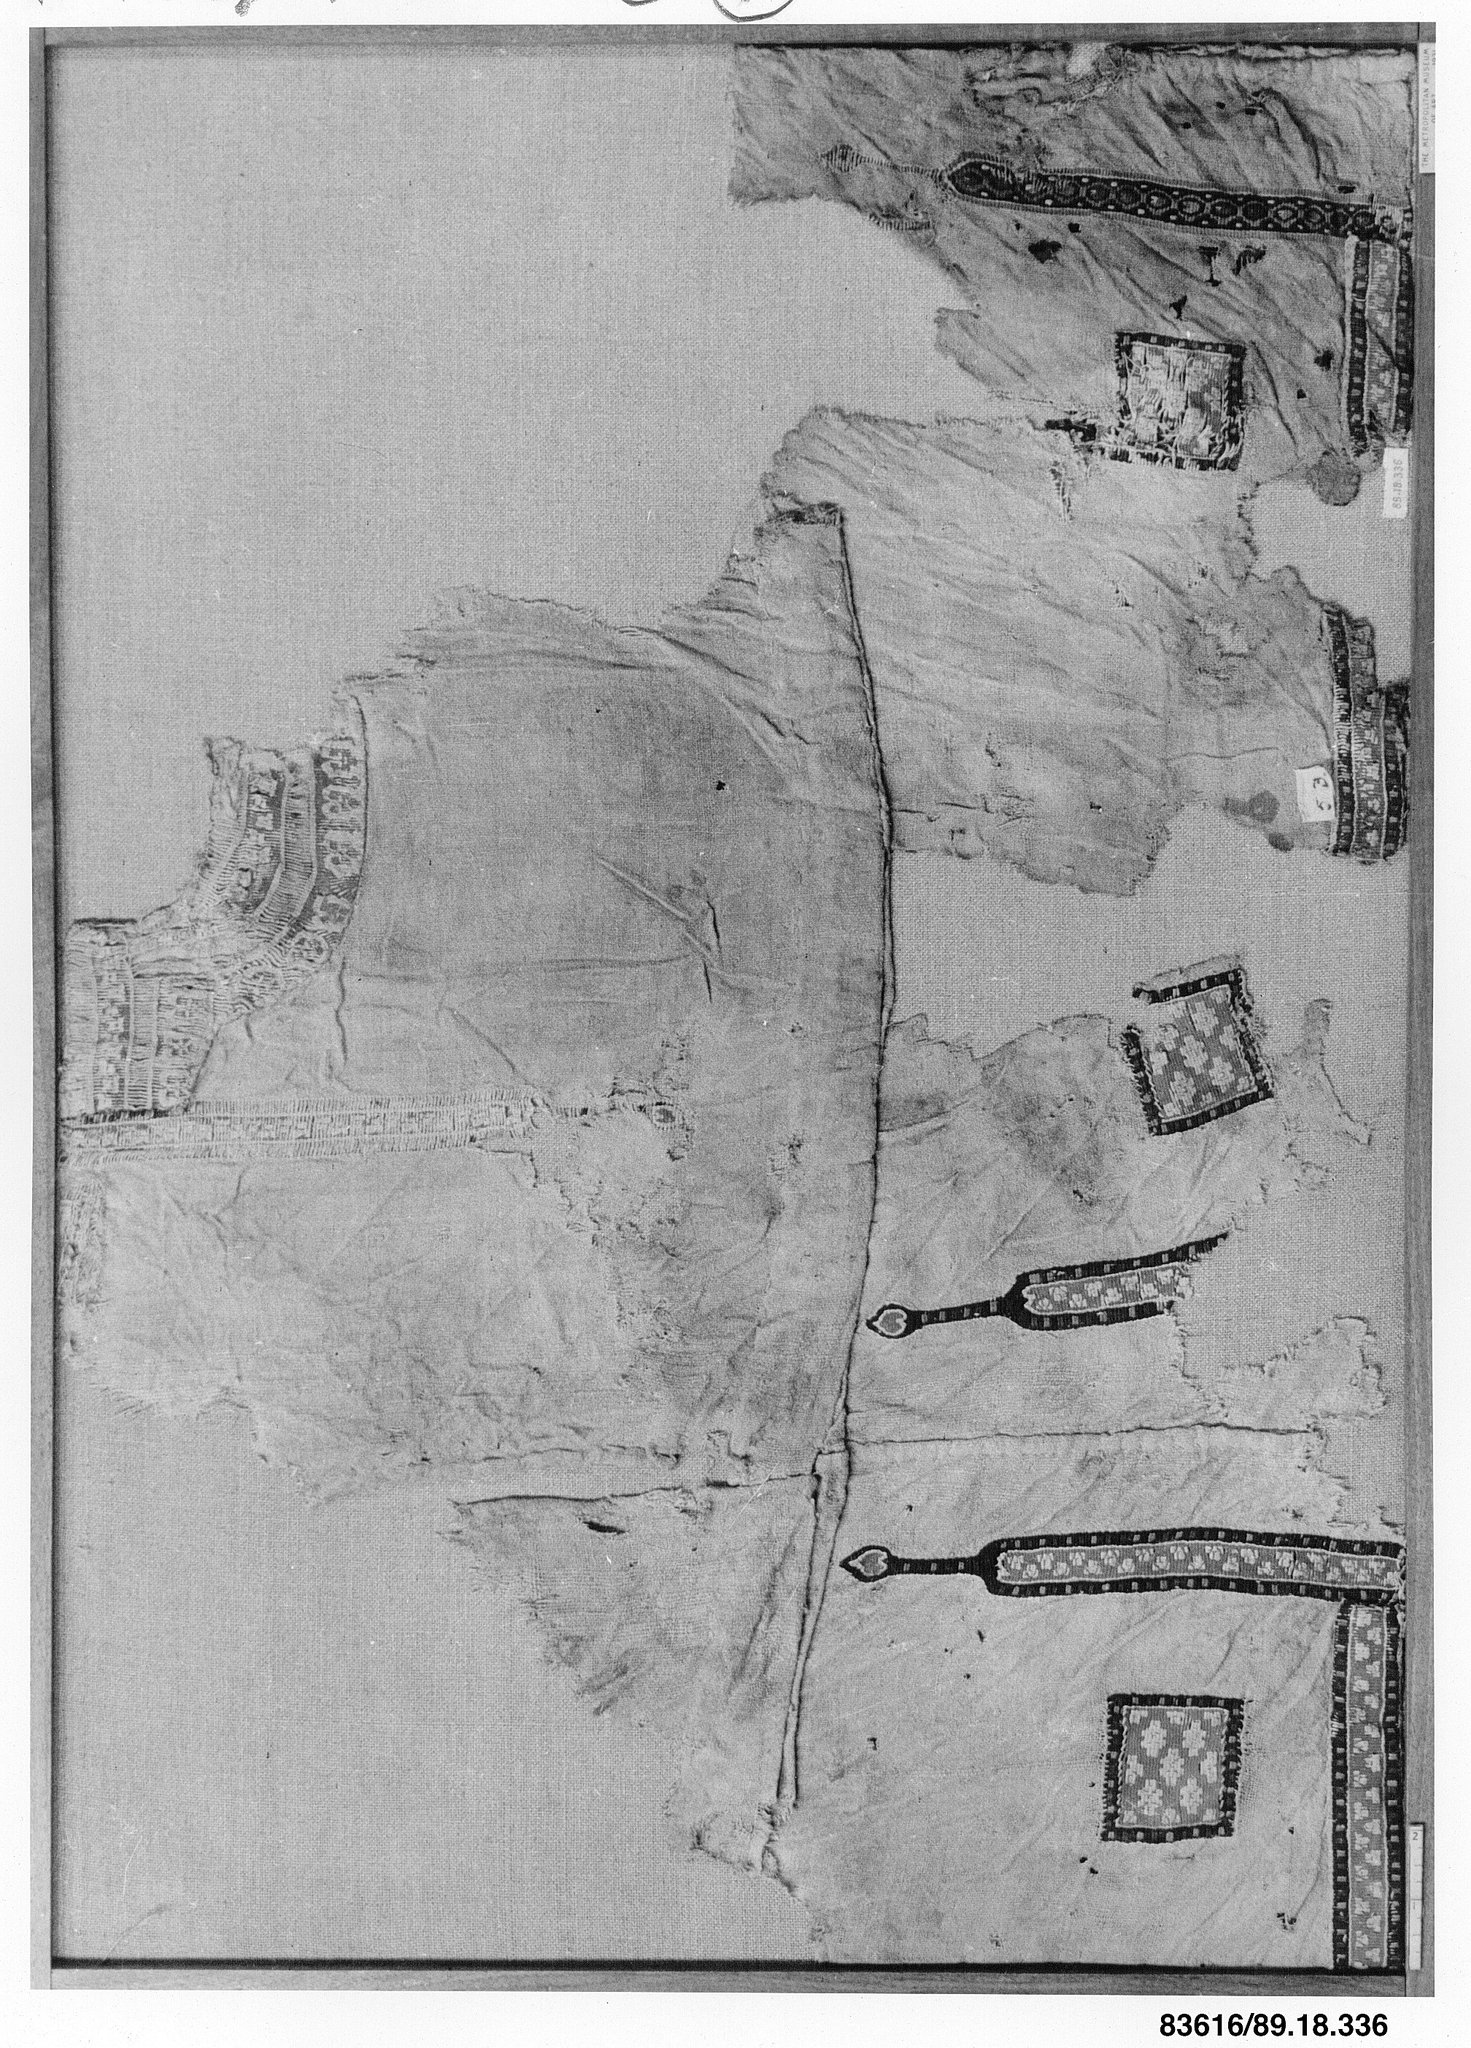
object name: textile fragment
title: Fragment of a Tunic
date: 401-600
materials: linen, wool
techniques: weave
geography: egypt